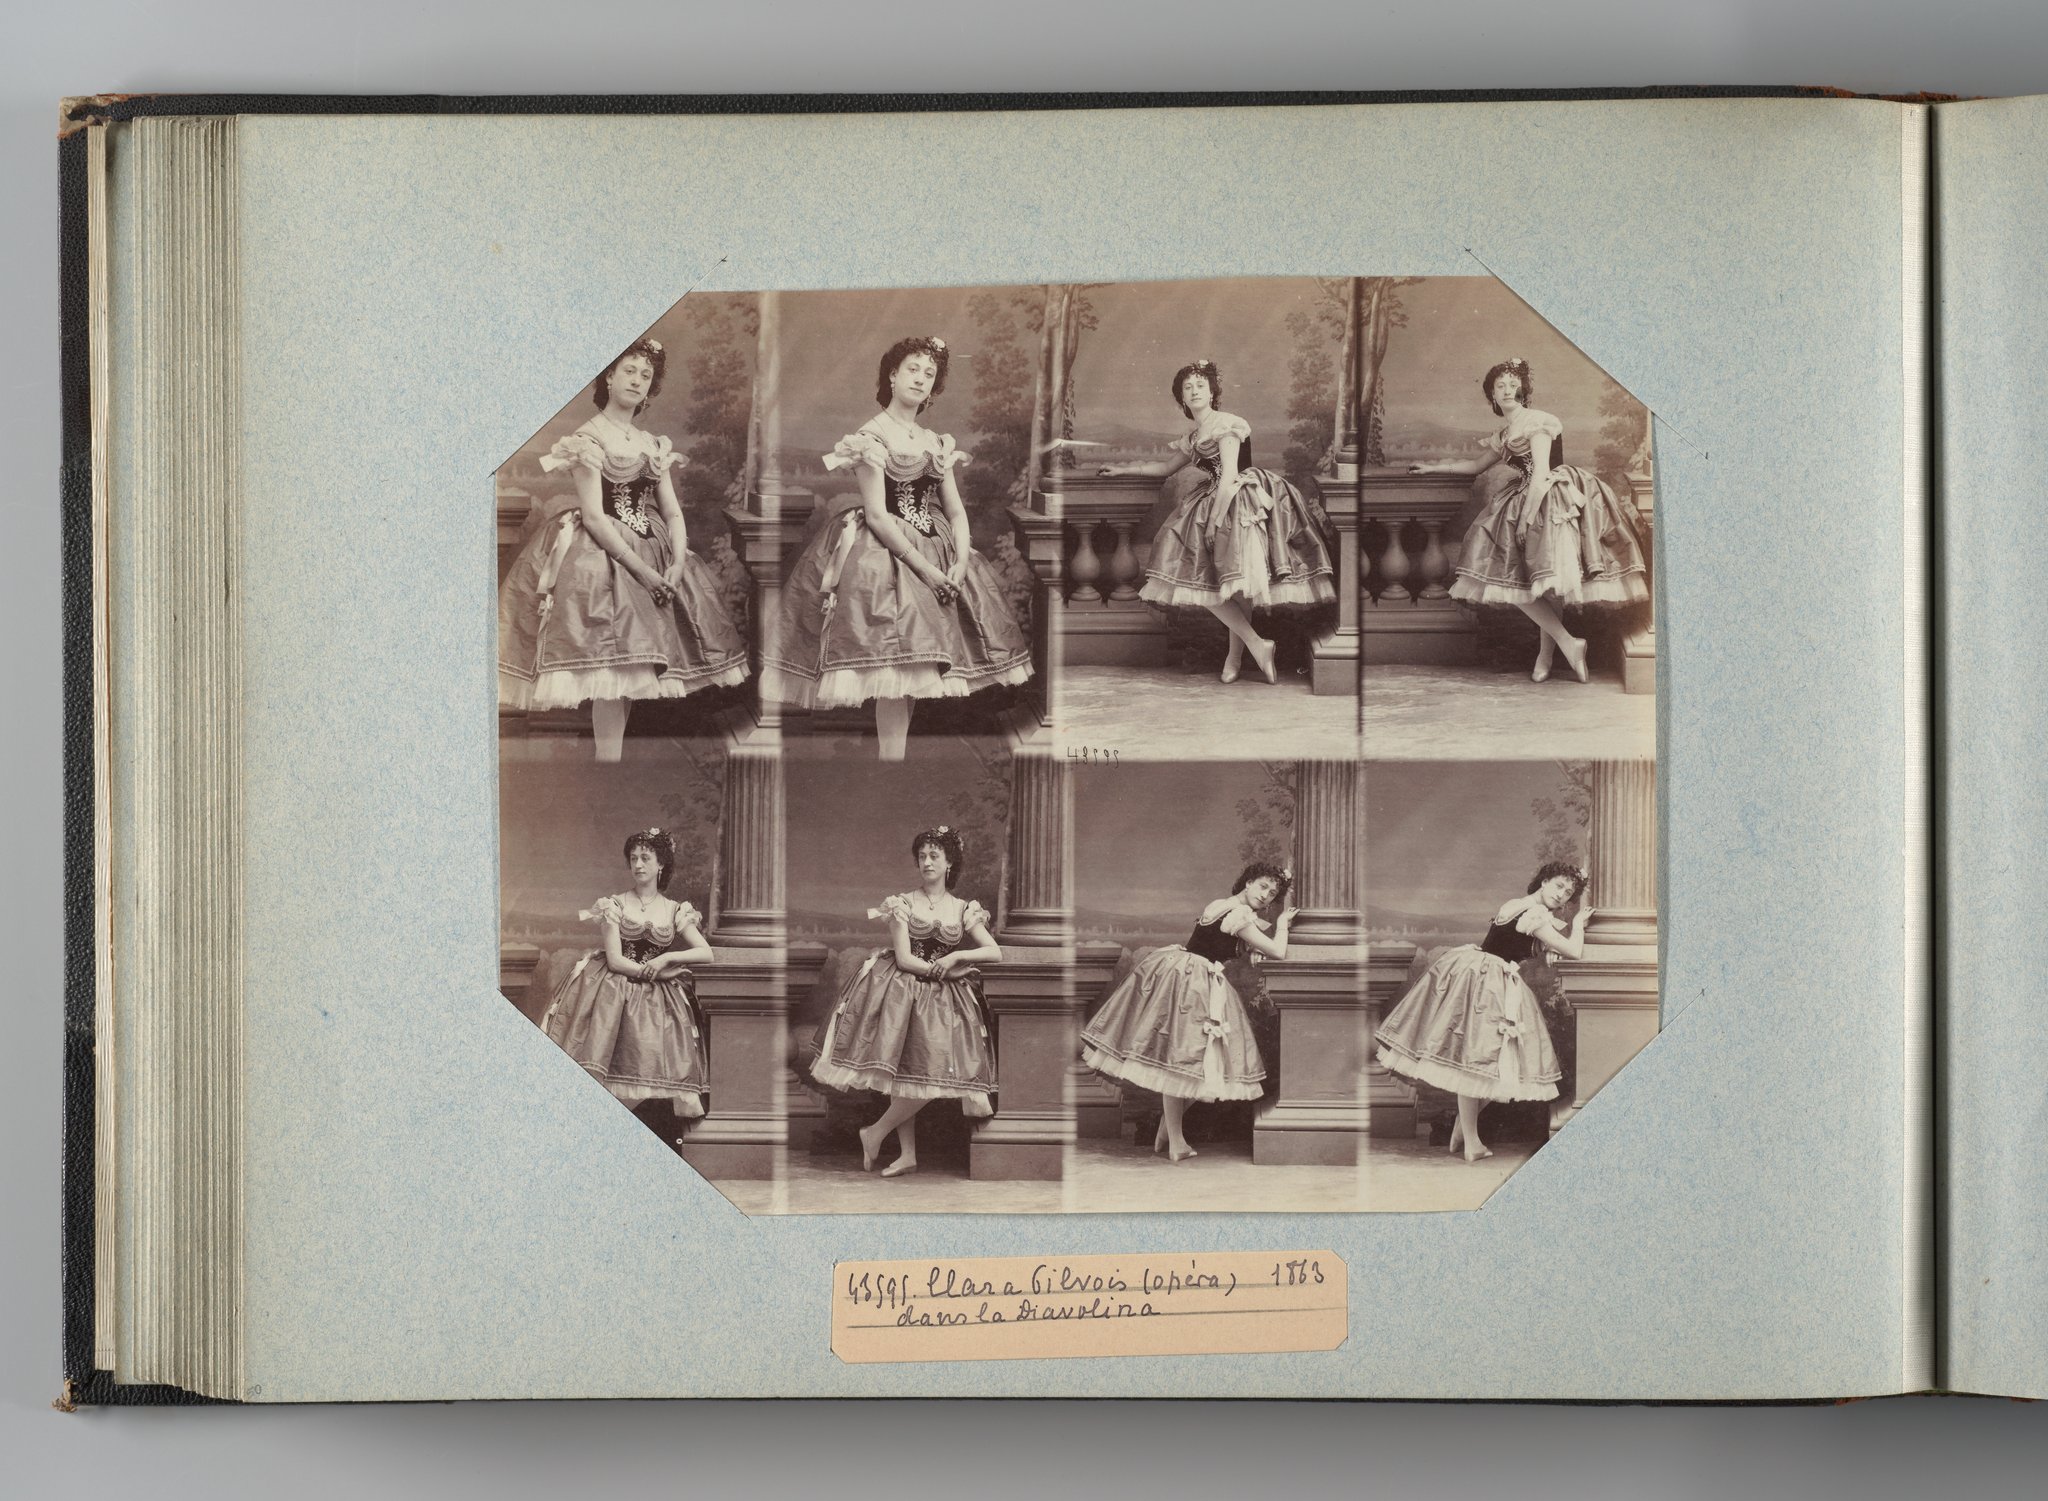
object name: photograph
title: Clara Pilvois dans la Diavolina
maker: andré-adolphe-eugène disdéri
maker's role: artist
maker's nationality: french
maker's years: 1819-1889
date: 1863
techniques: albumen silver print, glass negative